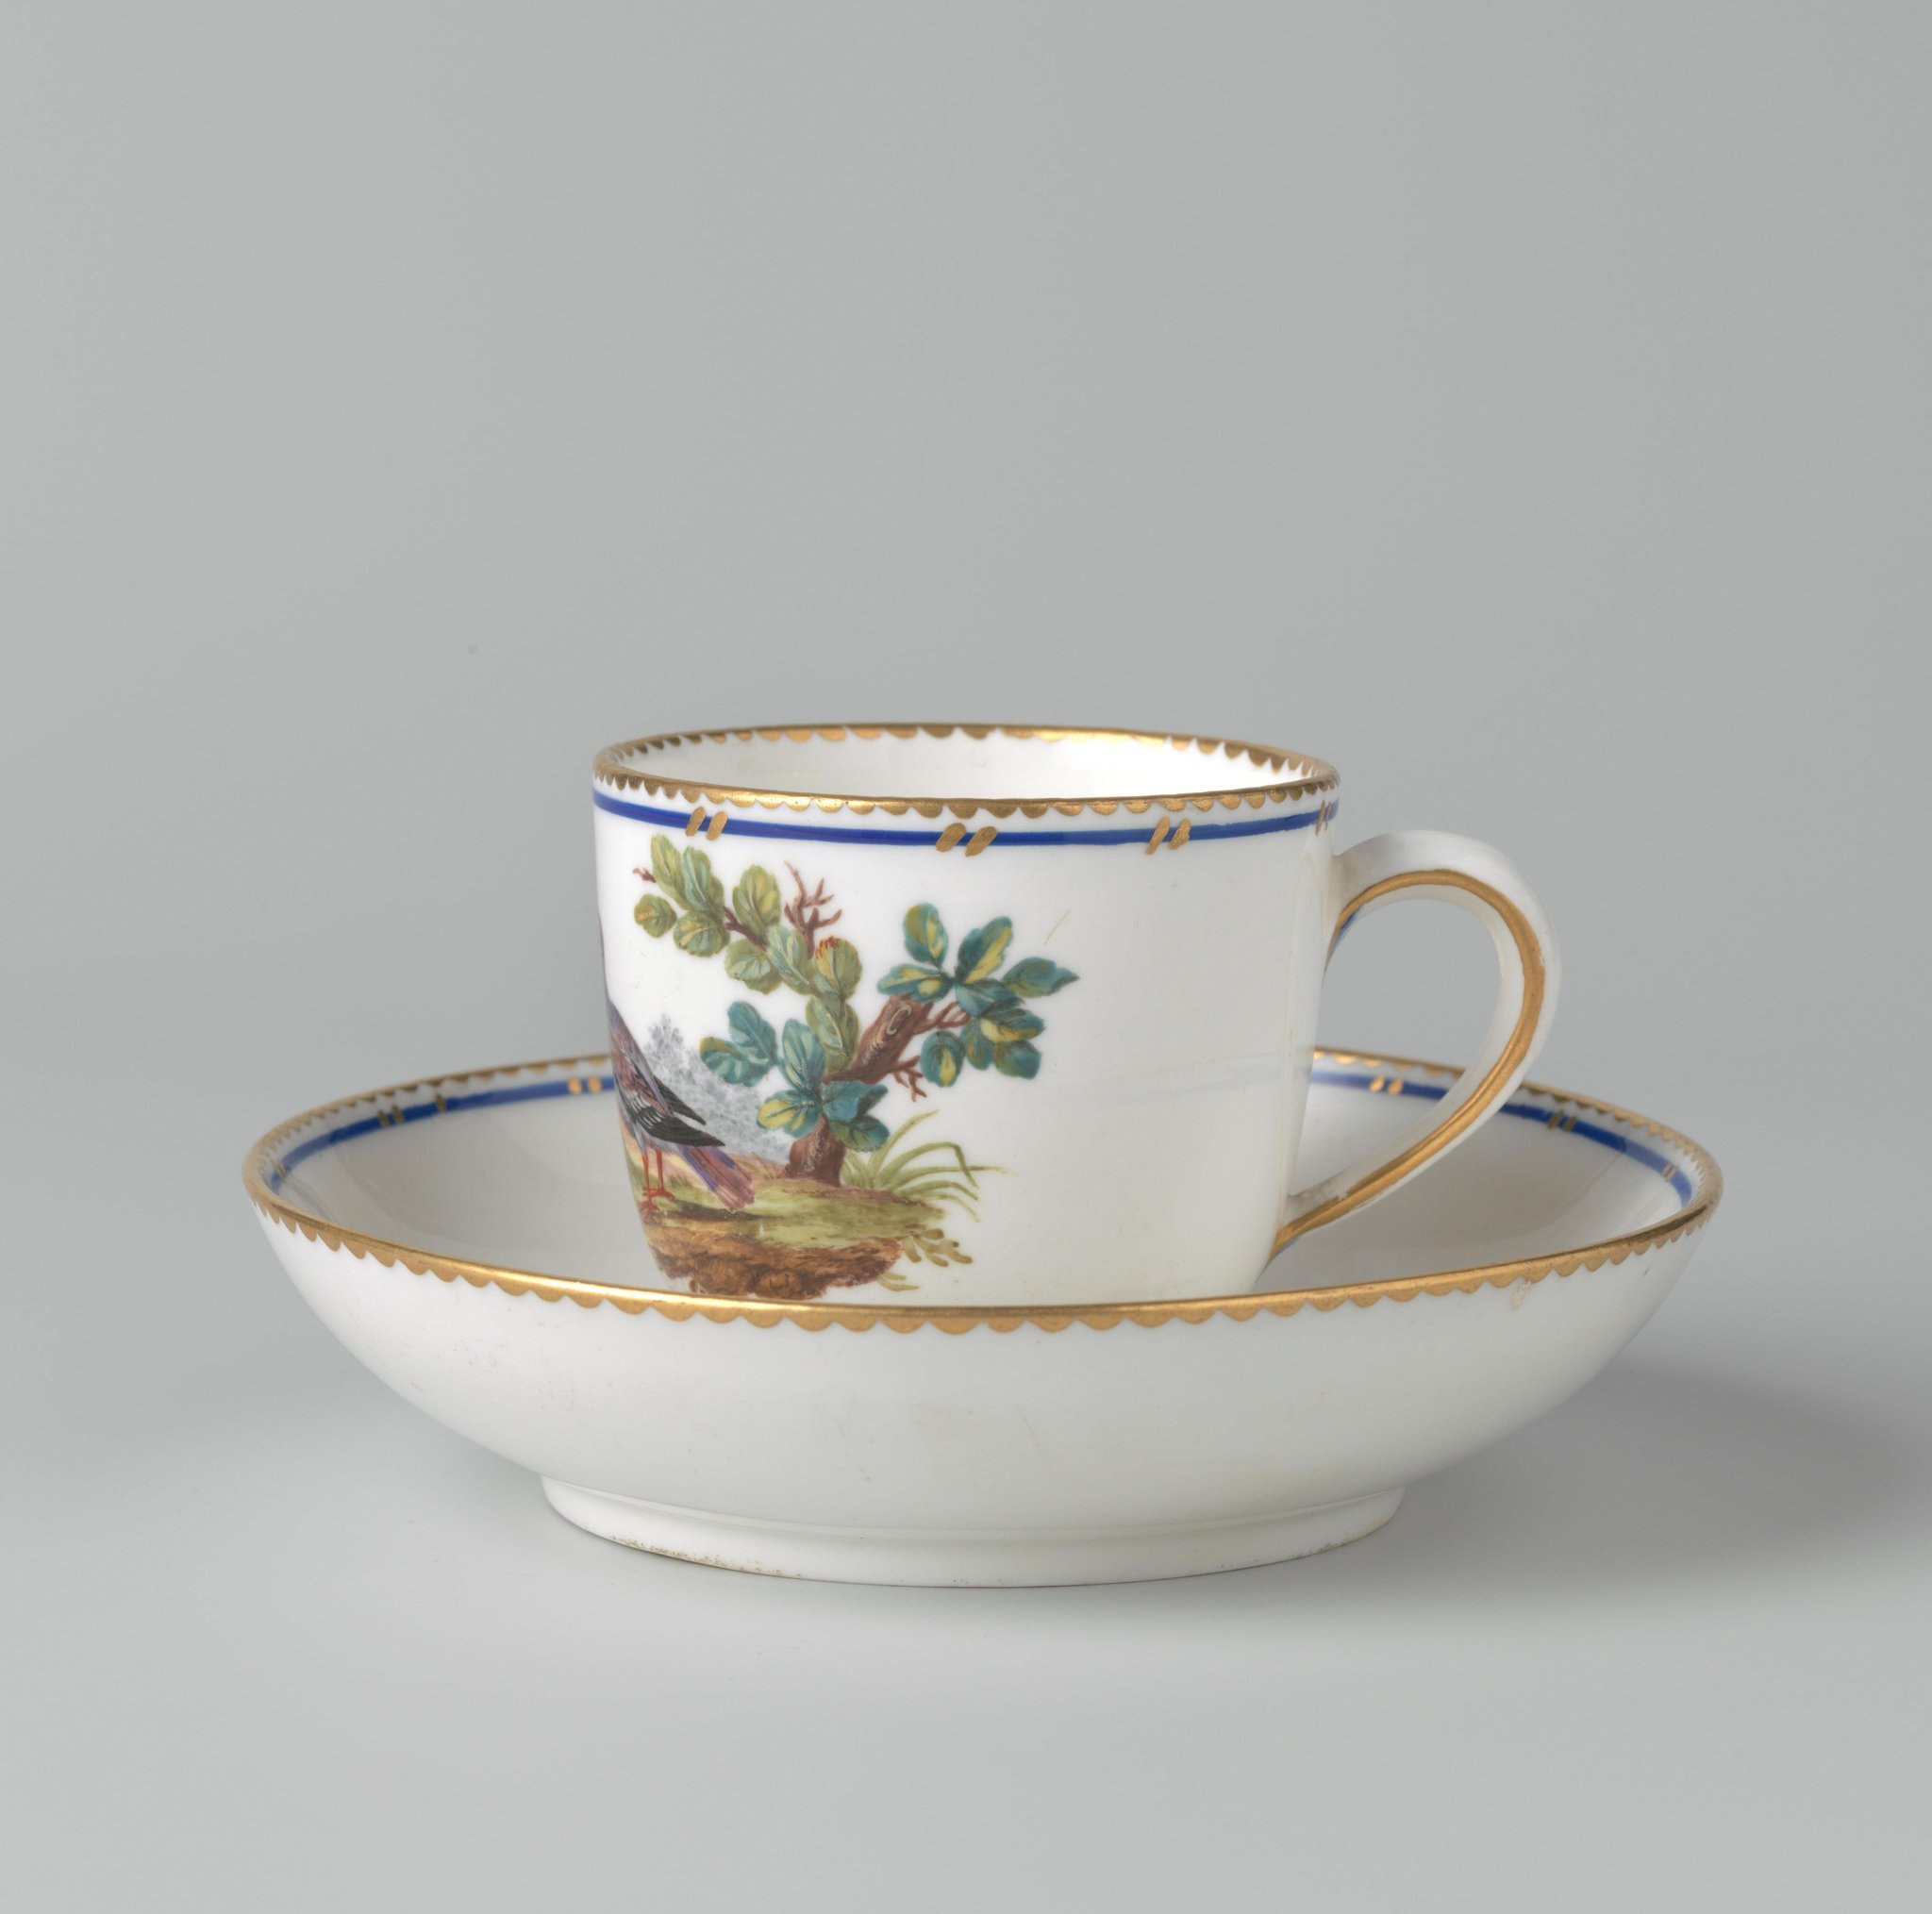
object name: cup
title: Cup with a bird in a landscape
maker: Anonymous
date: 1750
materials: glaze, gold, paint, porcelain, soft paste porcelain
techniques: firing, forming, gilding, turning, vitrification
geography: vincennes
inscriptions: mark: ‘dubbele L/ X/ S’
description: Kop van soft-paste porselein (pâte tendre) met C-vormig oor, beschilderd op het glazuur in emailkleuren en goud. Op de buitenwand een vogel in een landschap met bomen en planten. Op de voet en de buitenrand een blauwe lijn met telkens twee schuine, gouden strepen. Op de rand, aan de binnen- en buitenzijde een band van halve gouden bollen. Bakresidu op de voetring en daarboven. Gemerkt op de onderzijde met de dubbele L, X en S.